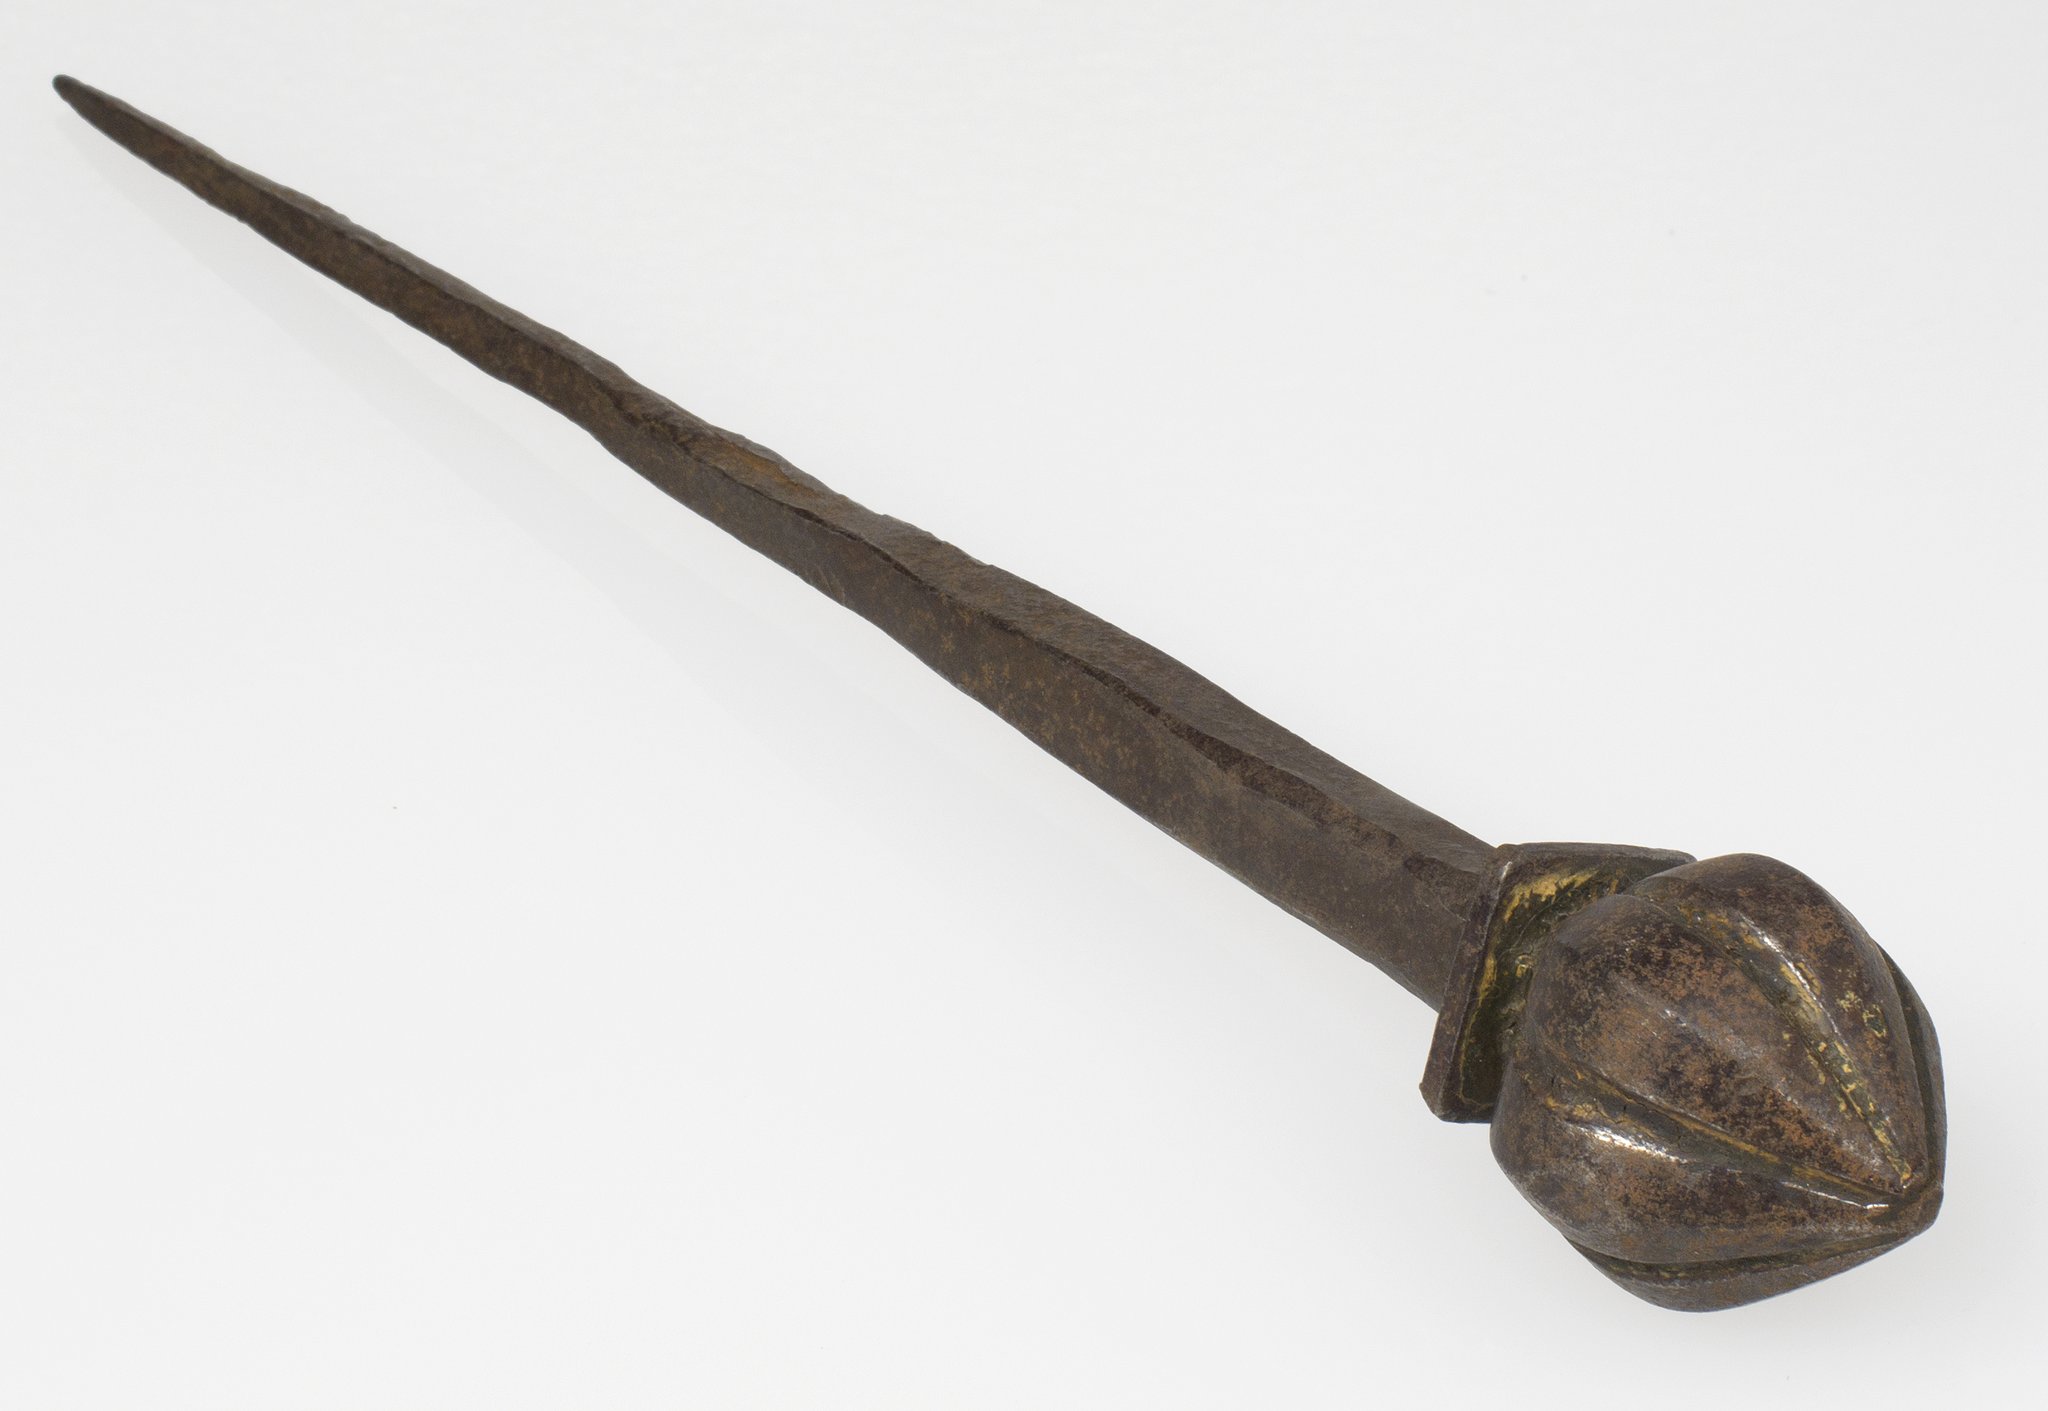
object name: nail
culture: european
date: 1401-1600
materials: iron